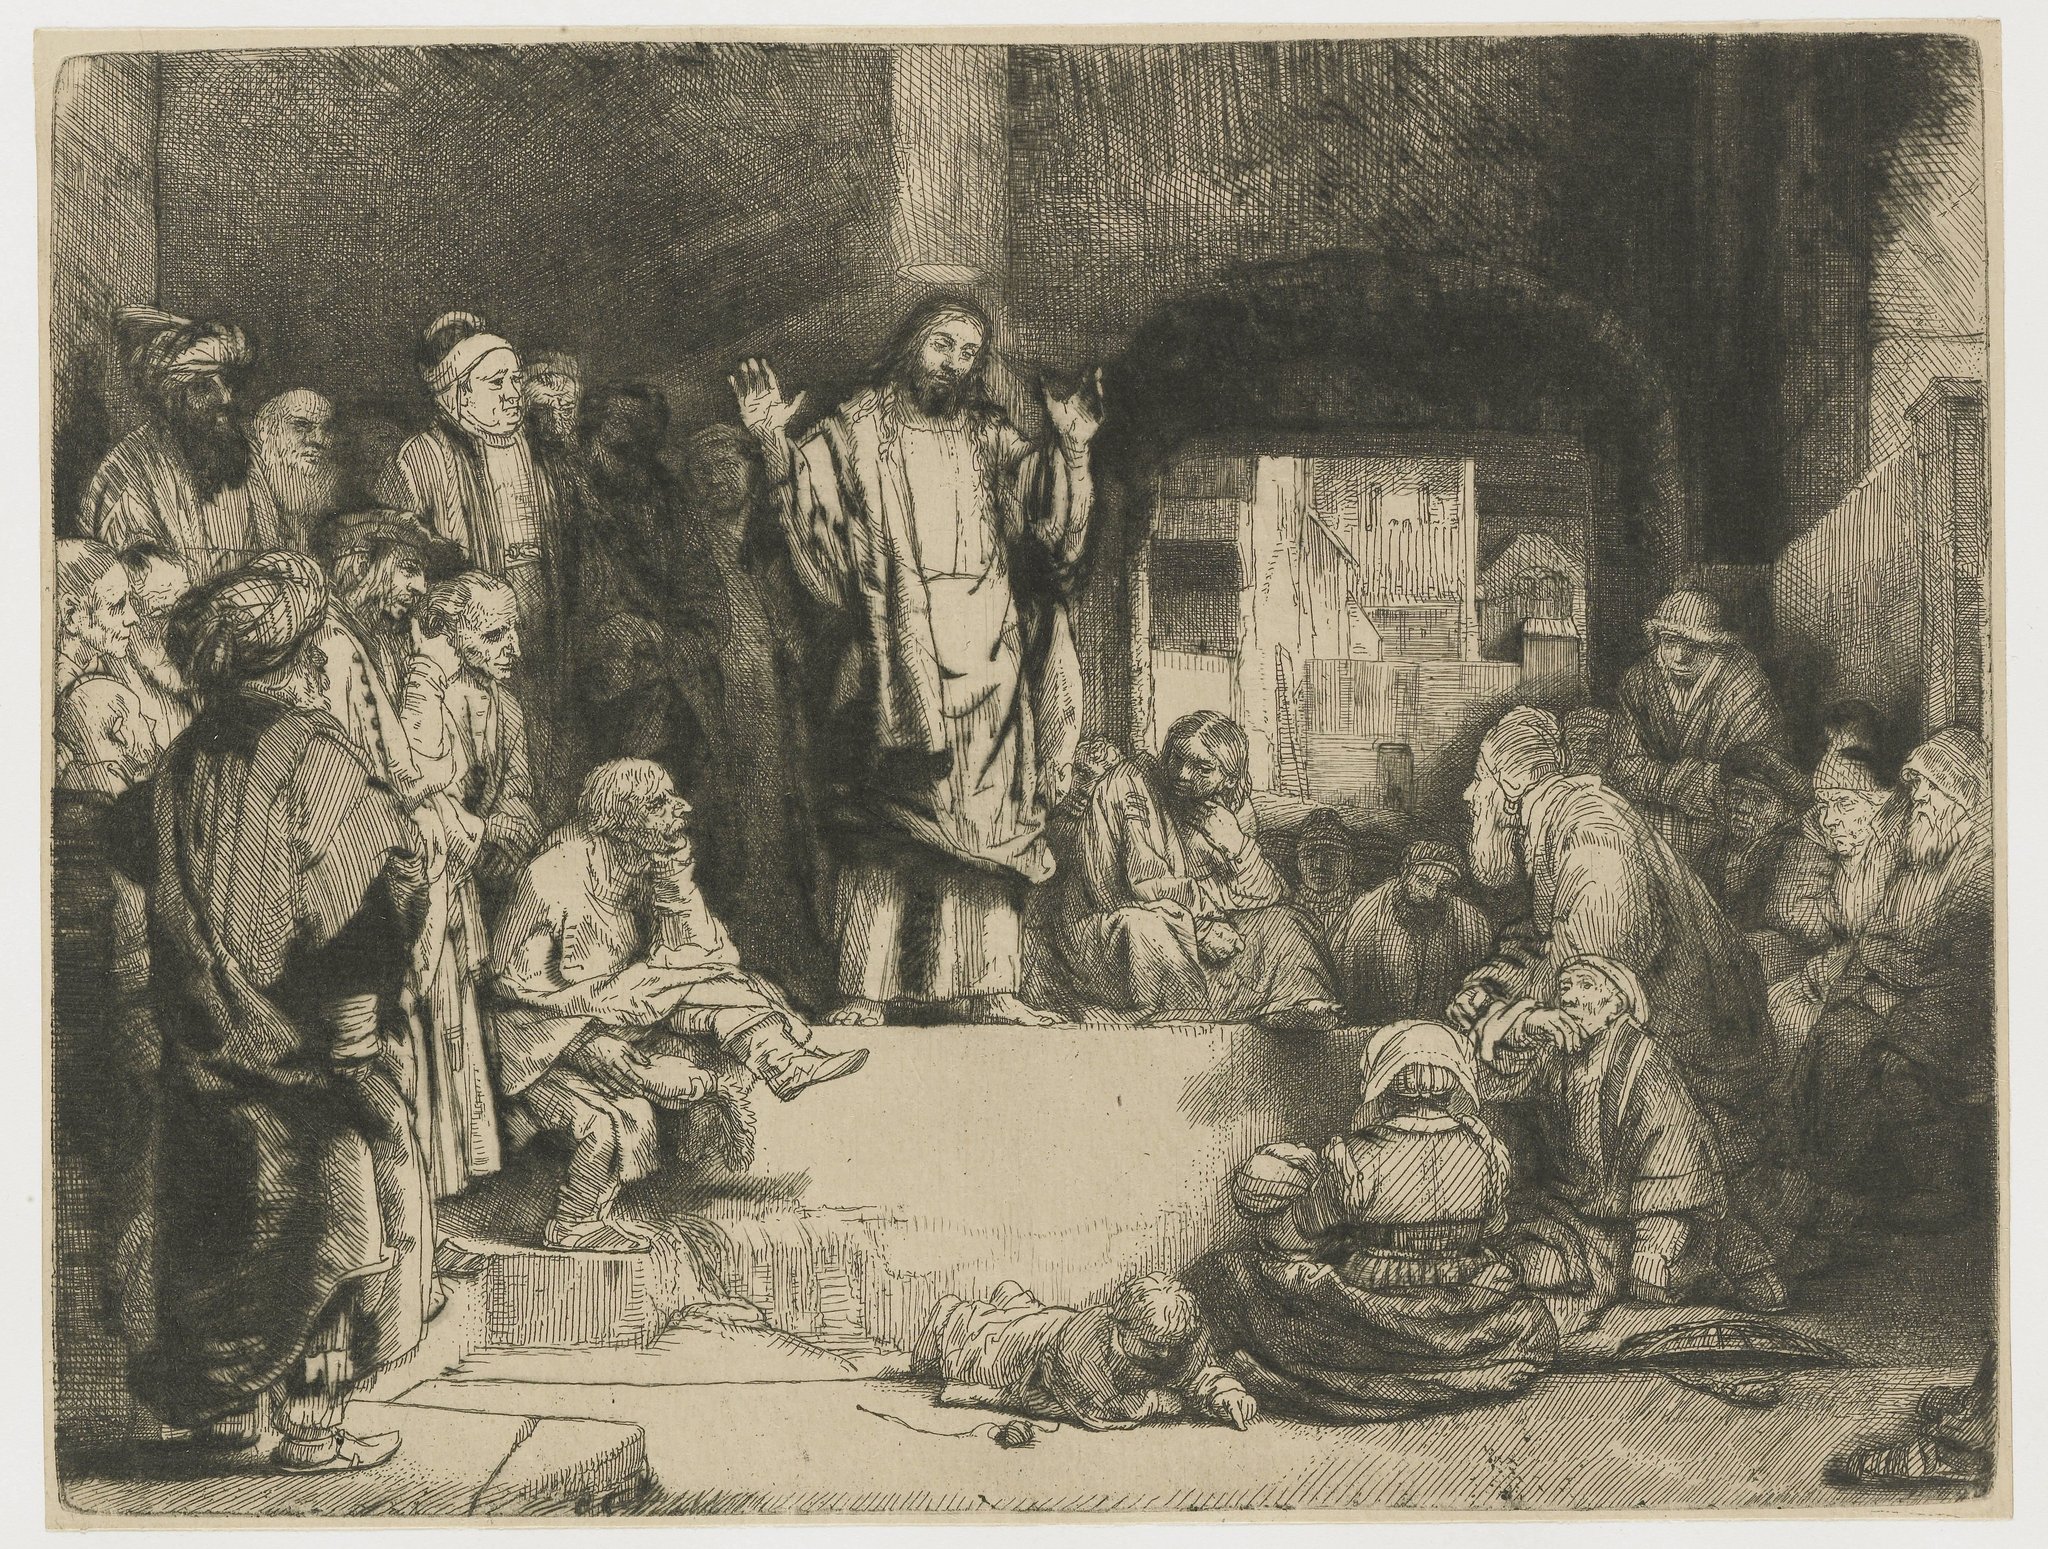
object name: print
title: Christ Preaching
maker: rembrandt van rijn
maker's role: draughtsman, painter, print maker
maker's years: 1606-1669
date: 1657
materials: paper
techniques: drypoint, etching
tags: christ preaching or teaching (in general)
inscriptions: collector's mark: Lugt 240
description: Christ preaches to a small circle of people. While the adults listen with baited breath, in the foreground a child lies drawing in the sand. The gathering is taking too long for him. In the 17th century, this scene was also referred to as ‘Latombisch printje’ or ‘La Petite Tombe’, after the Amsterdam printseller Pieter de la Tombe. Presumably he commissioned or owned the copperplate.